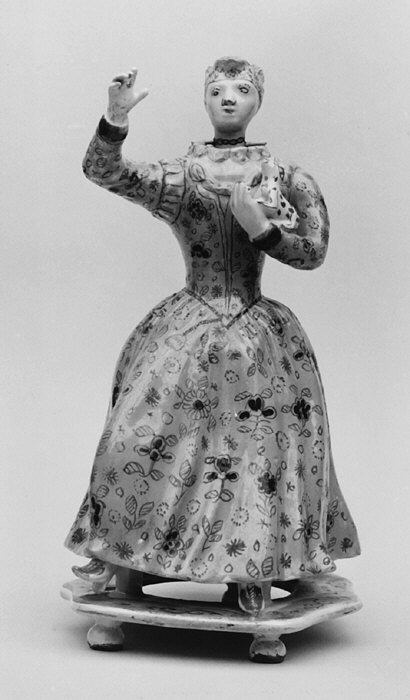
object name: figure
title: Standing woman holding a dog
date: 1750-1780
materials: faience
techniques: glazing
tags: women